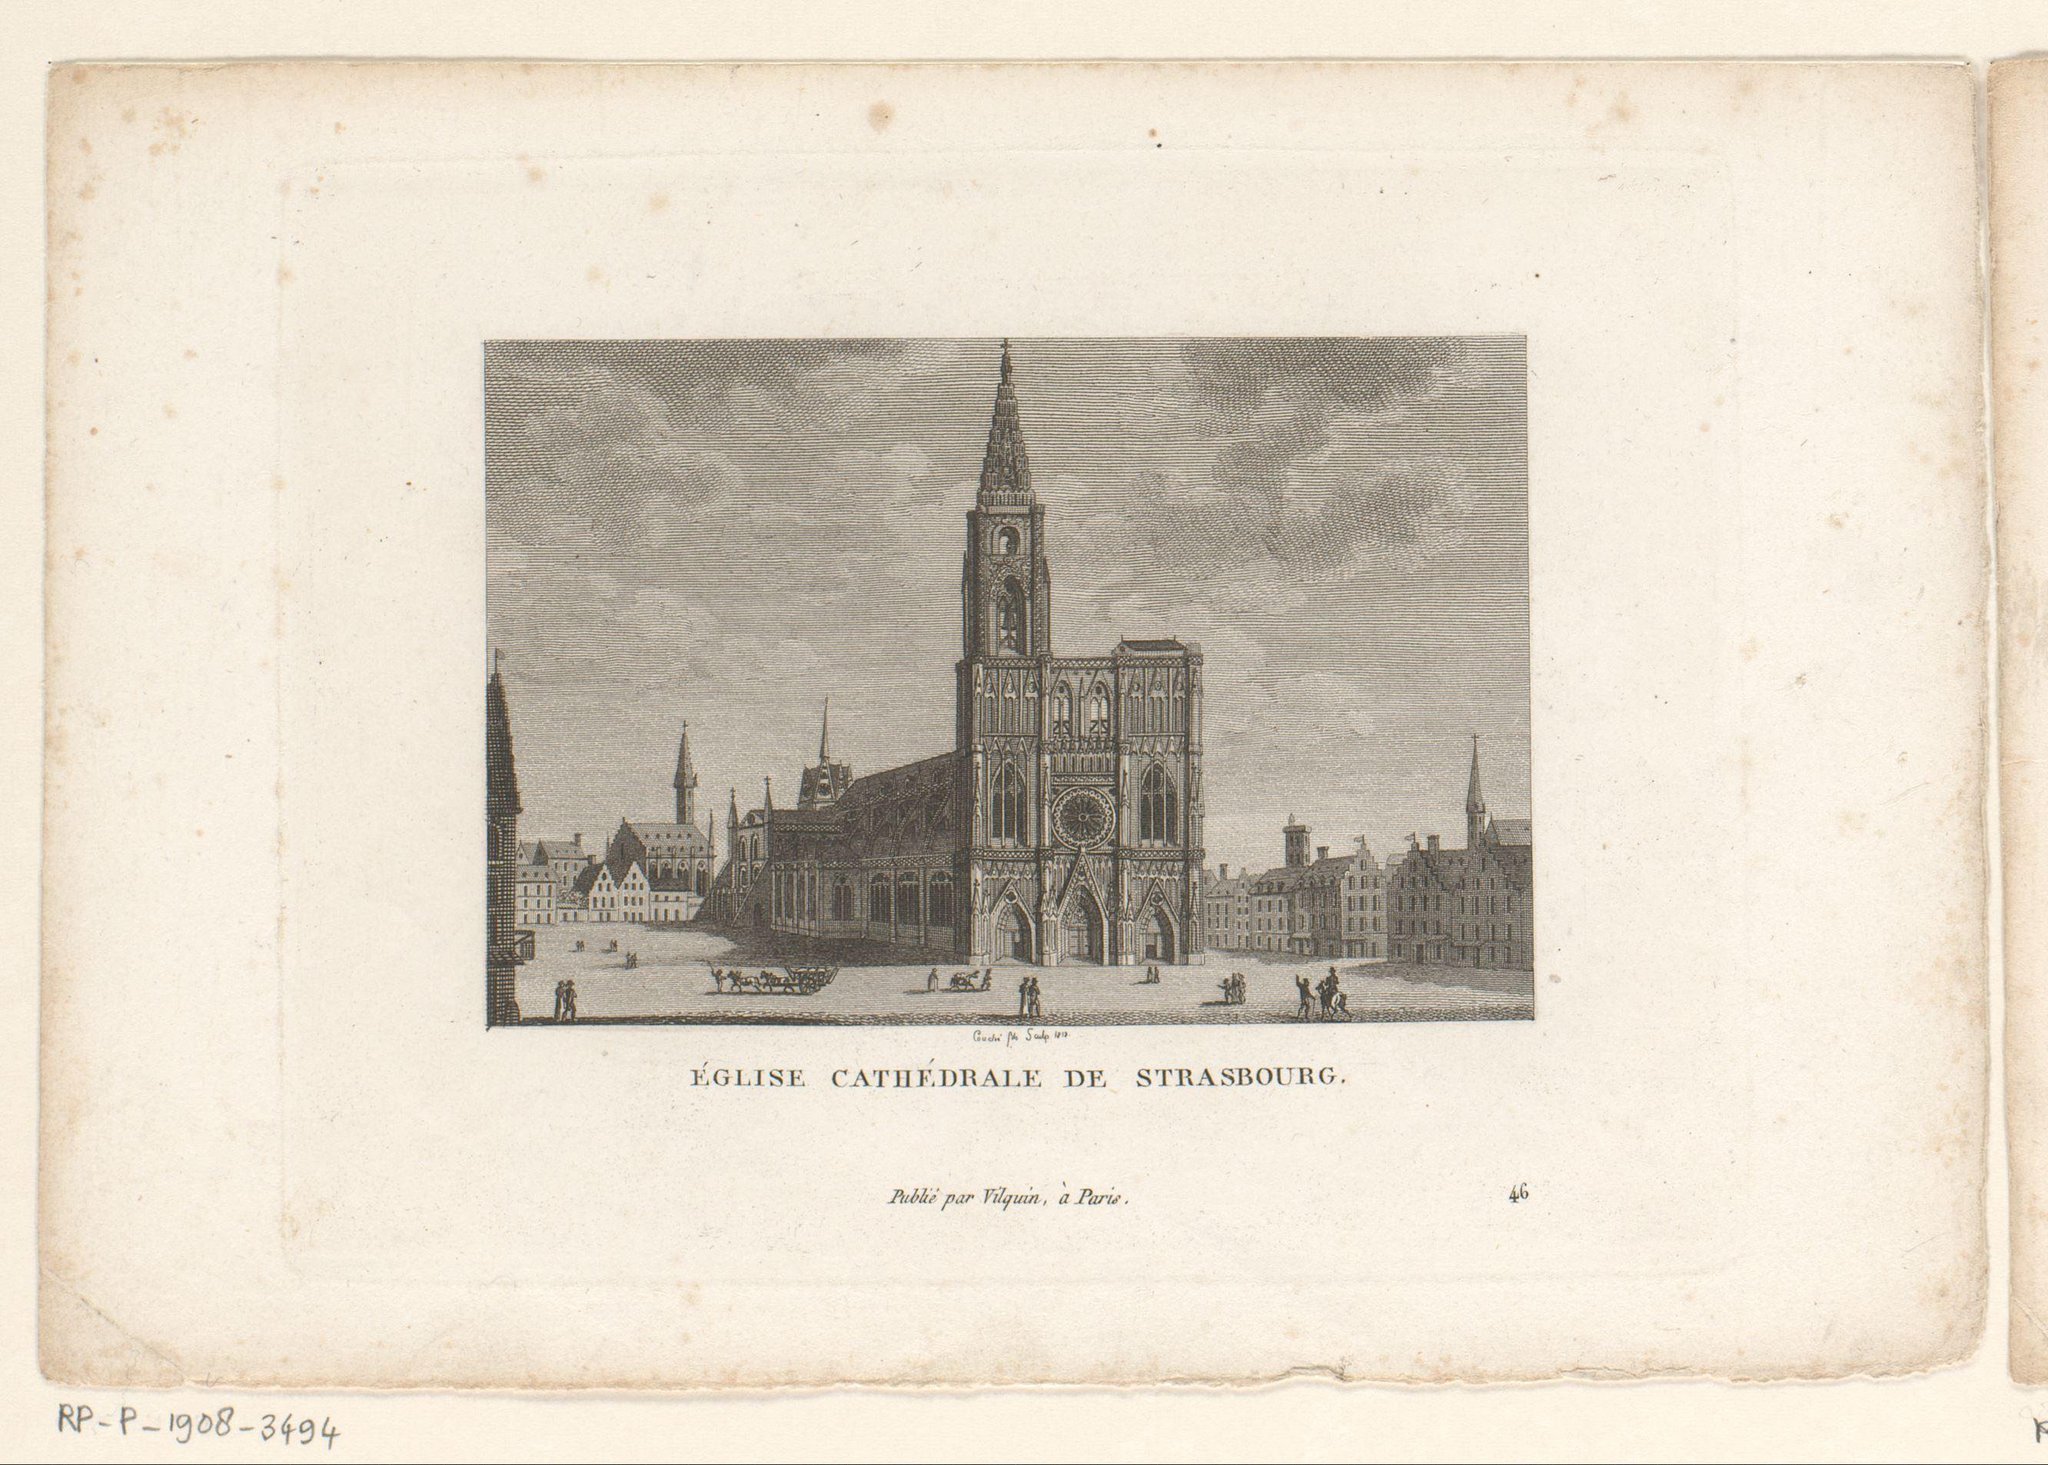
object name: print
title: Gezichten op Parijs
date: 1818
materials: paper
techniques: etching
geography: paris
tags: city-view in general; 'veduta'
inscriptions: collector's mark: Lugt 2228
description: Maakt deel uit van een serie met 60 platen van monumenten, kathedralen en paleizen in Parijs.